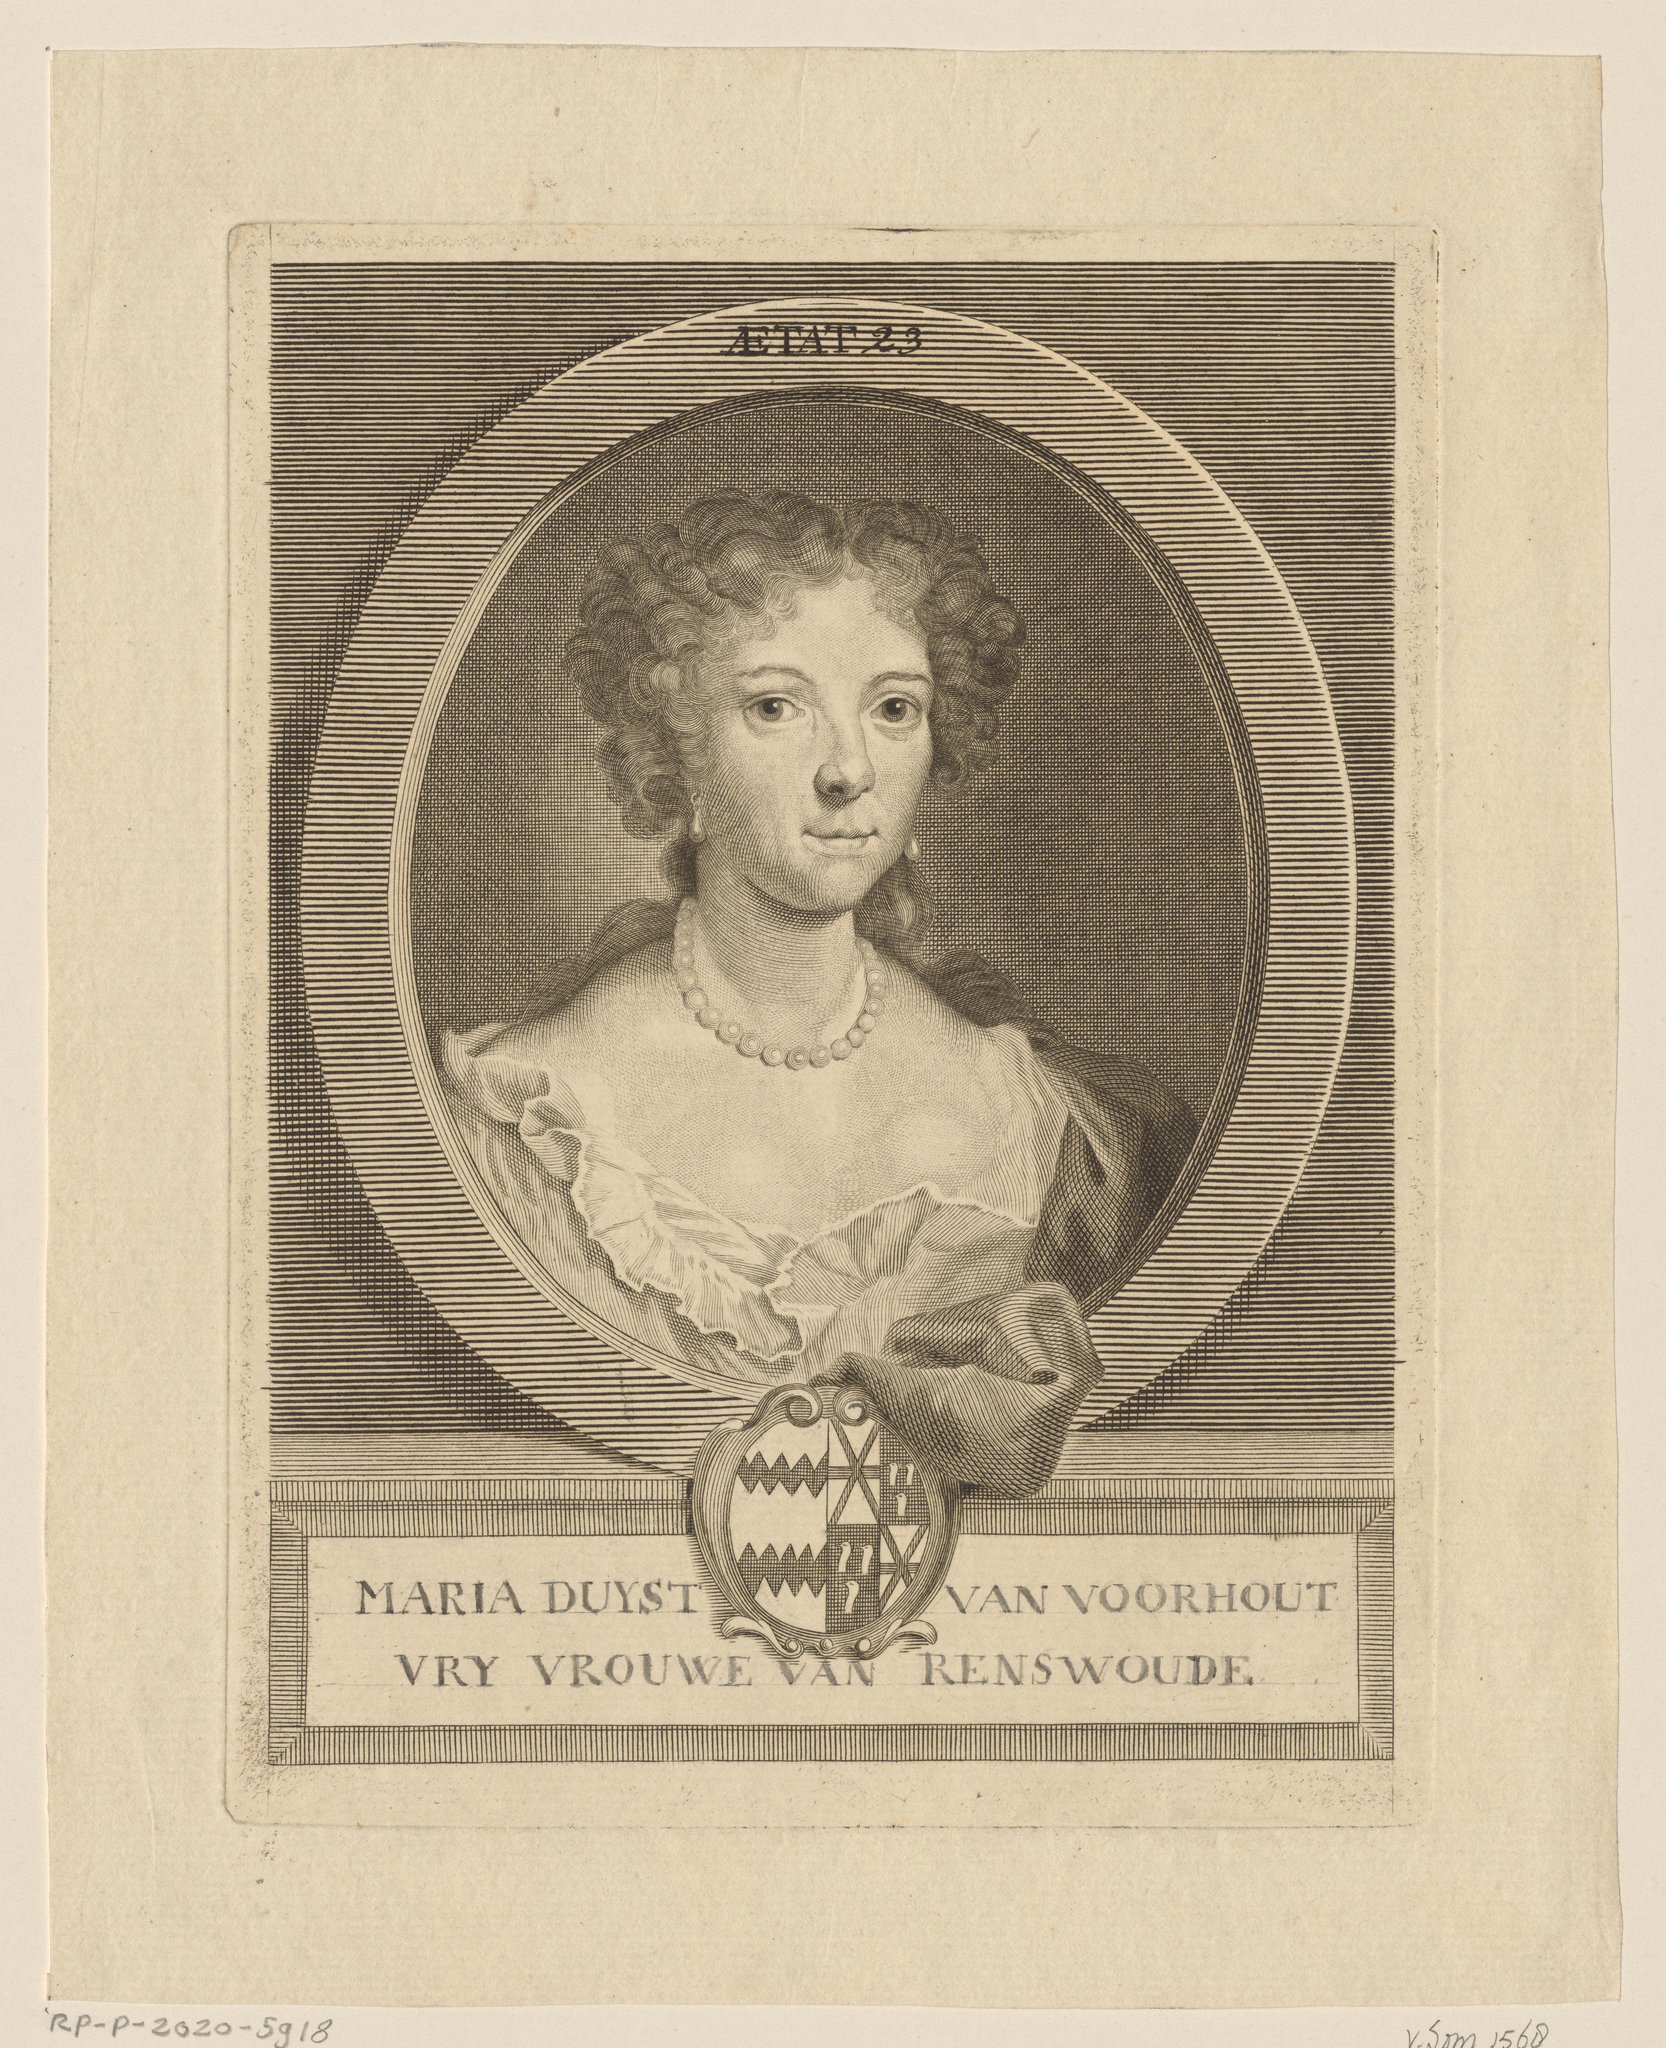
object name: print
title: Portret van Maria Duyst van Voorhout op 23-jarige leeftijd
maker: pieter willem van megen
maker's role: print maker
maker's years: 1750-1785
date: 1780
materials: ink, paper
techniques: engraving, pen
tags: utrecht, historical persons - bb - woman, orphanage